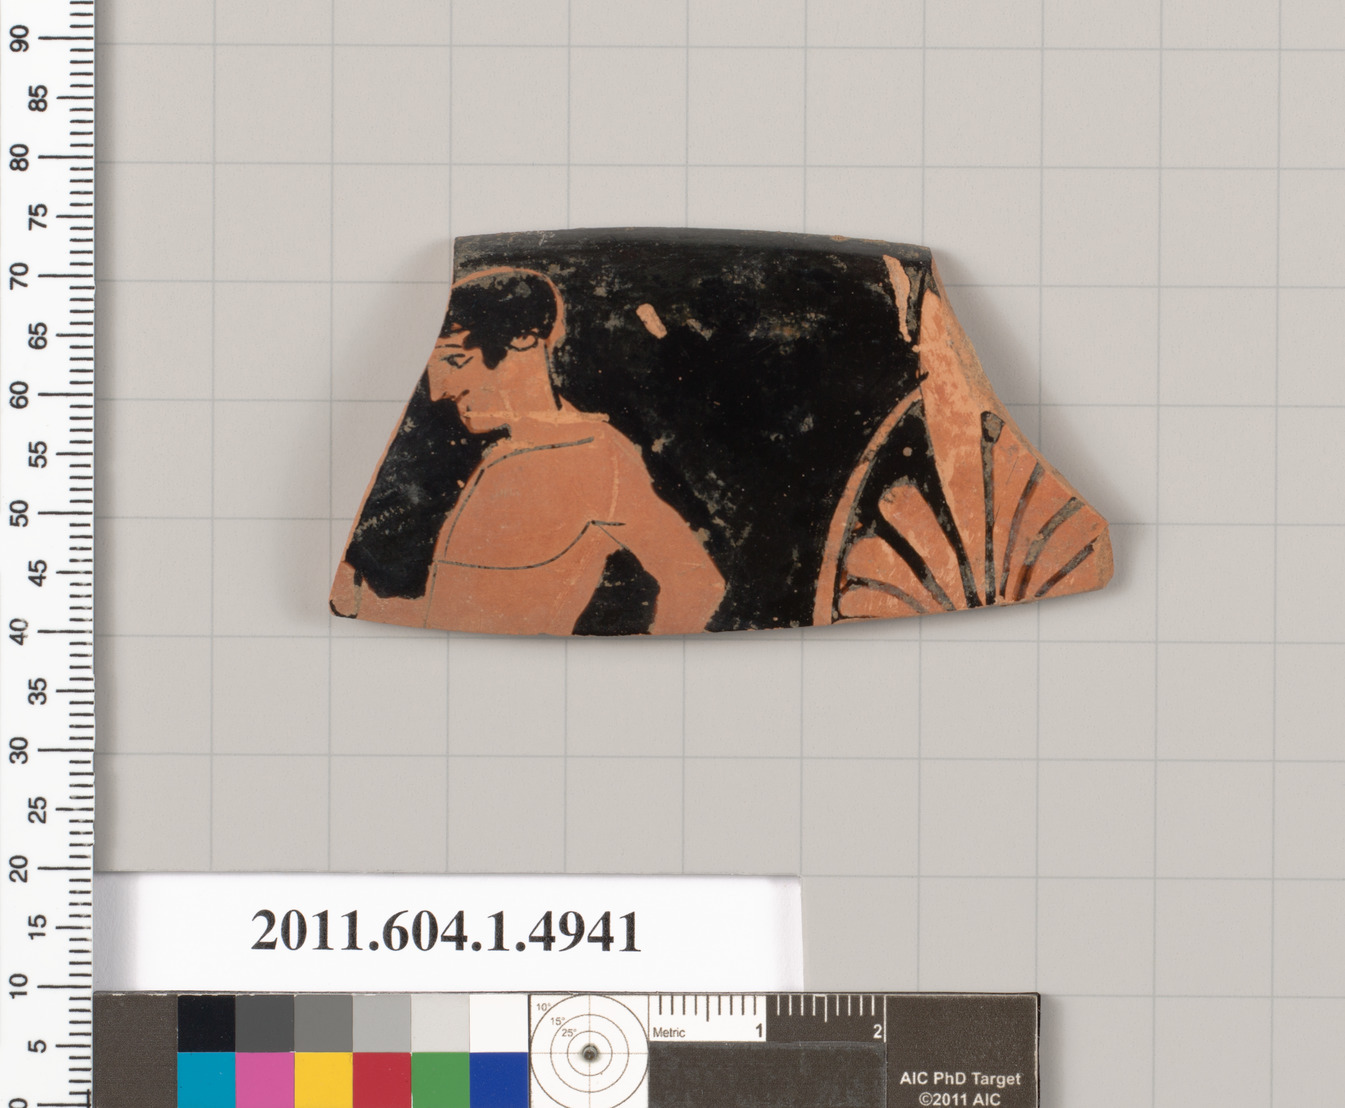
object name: kylix fragment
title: Terracotta rim fragment of a kylix (drinking cup)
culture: greek, attic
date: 467-435 BCE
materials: terracotta